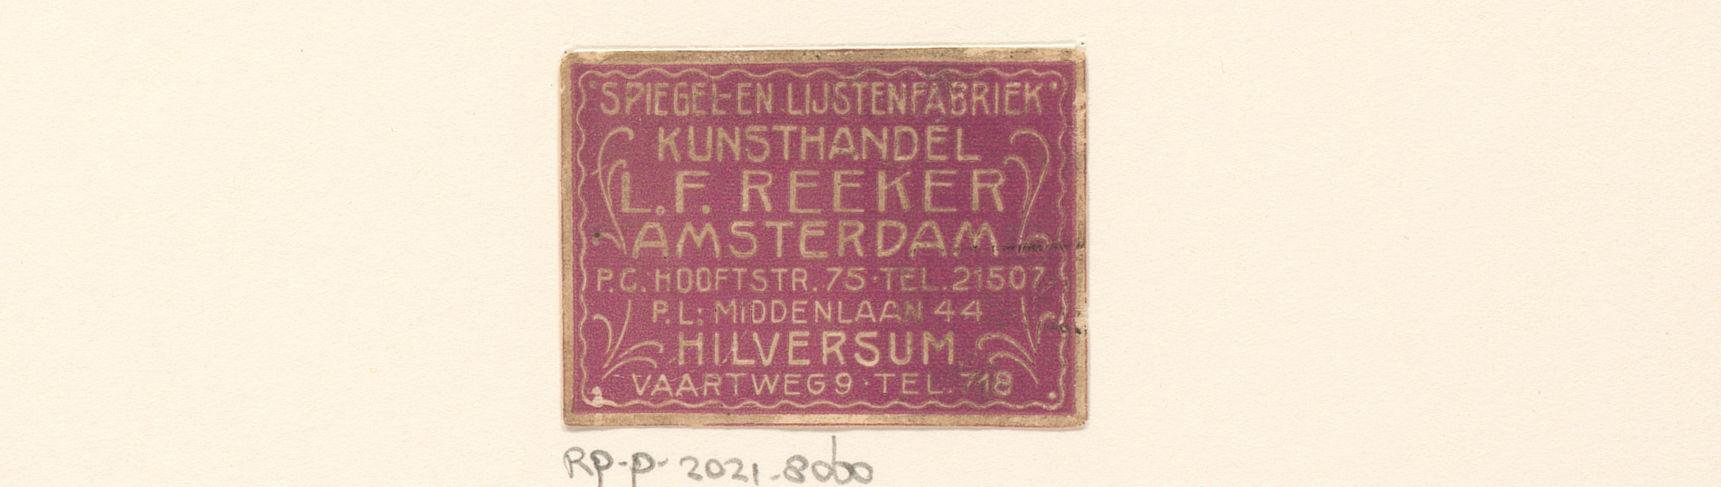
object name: photomechanical print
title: Etiket van kunsthandel L.F. Reeker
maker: Anonymous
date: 1924-1950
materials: paper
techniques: printing block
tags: printed matter, amsterdam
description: Etiket van 'Spiegel- en lijstenfabriek, kunsthandel L.F. Reeker' met adressen in Amsterdam en Hilversum.